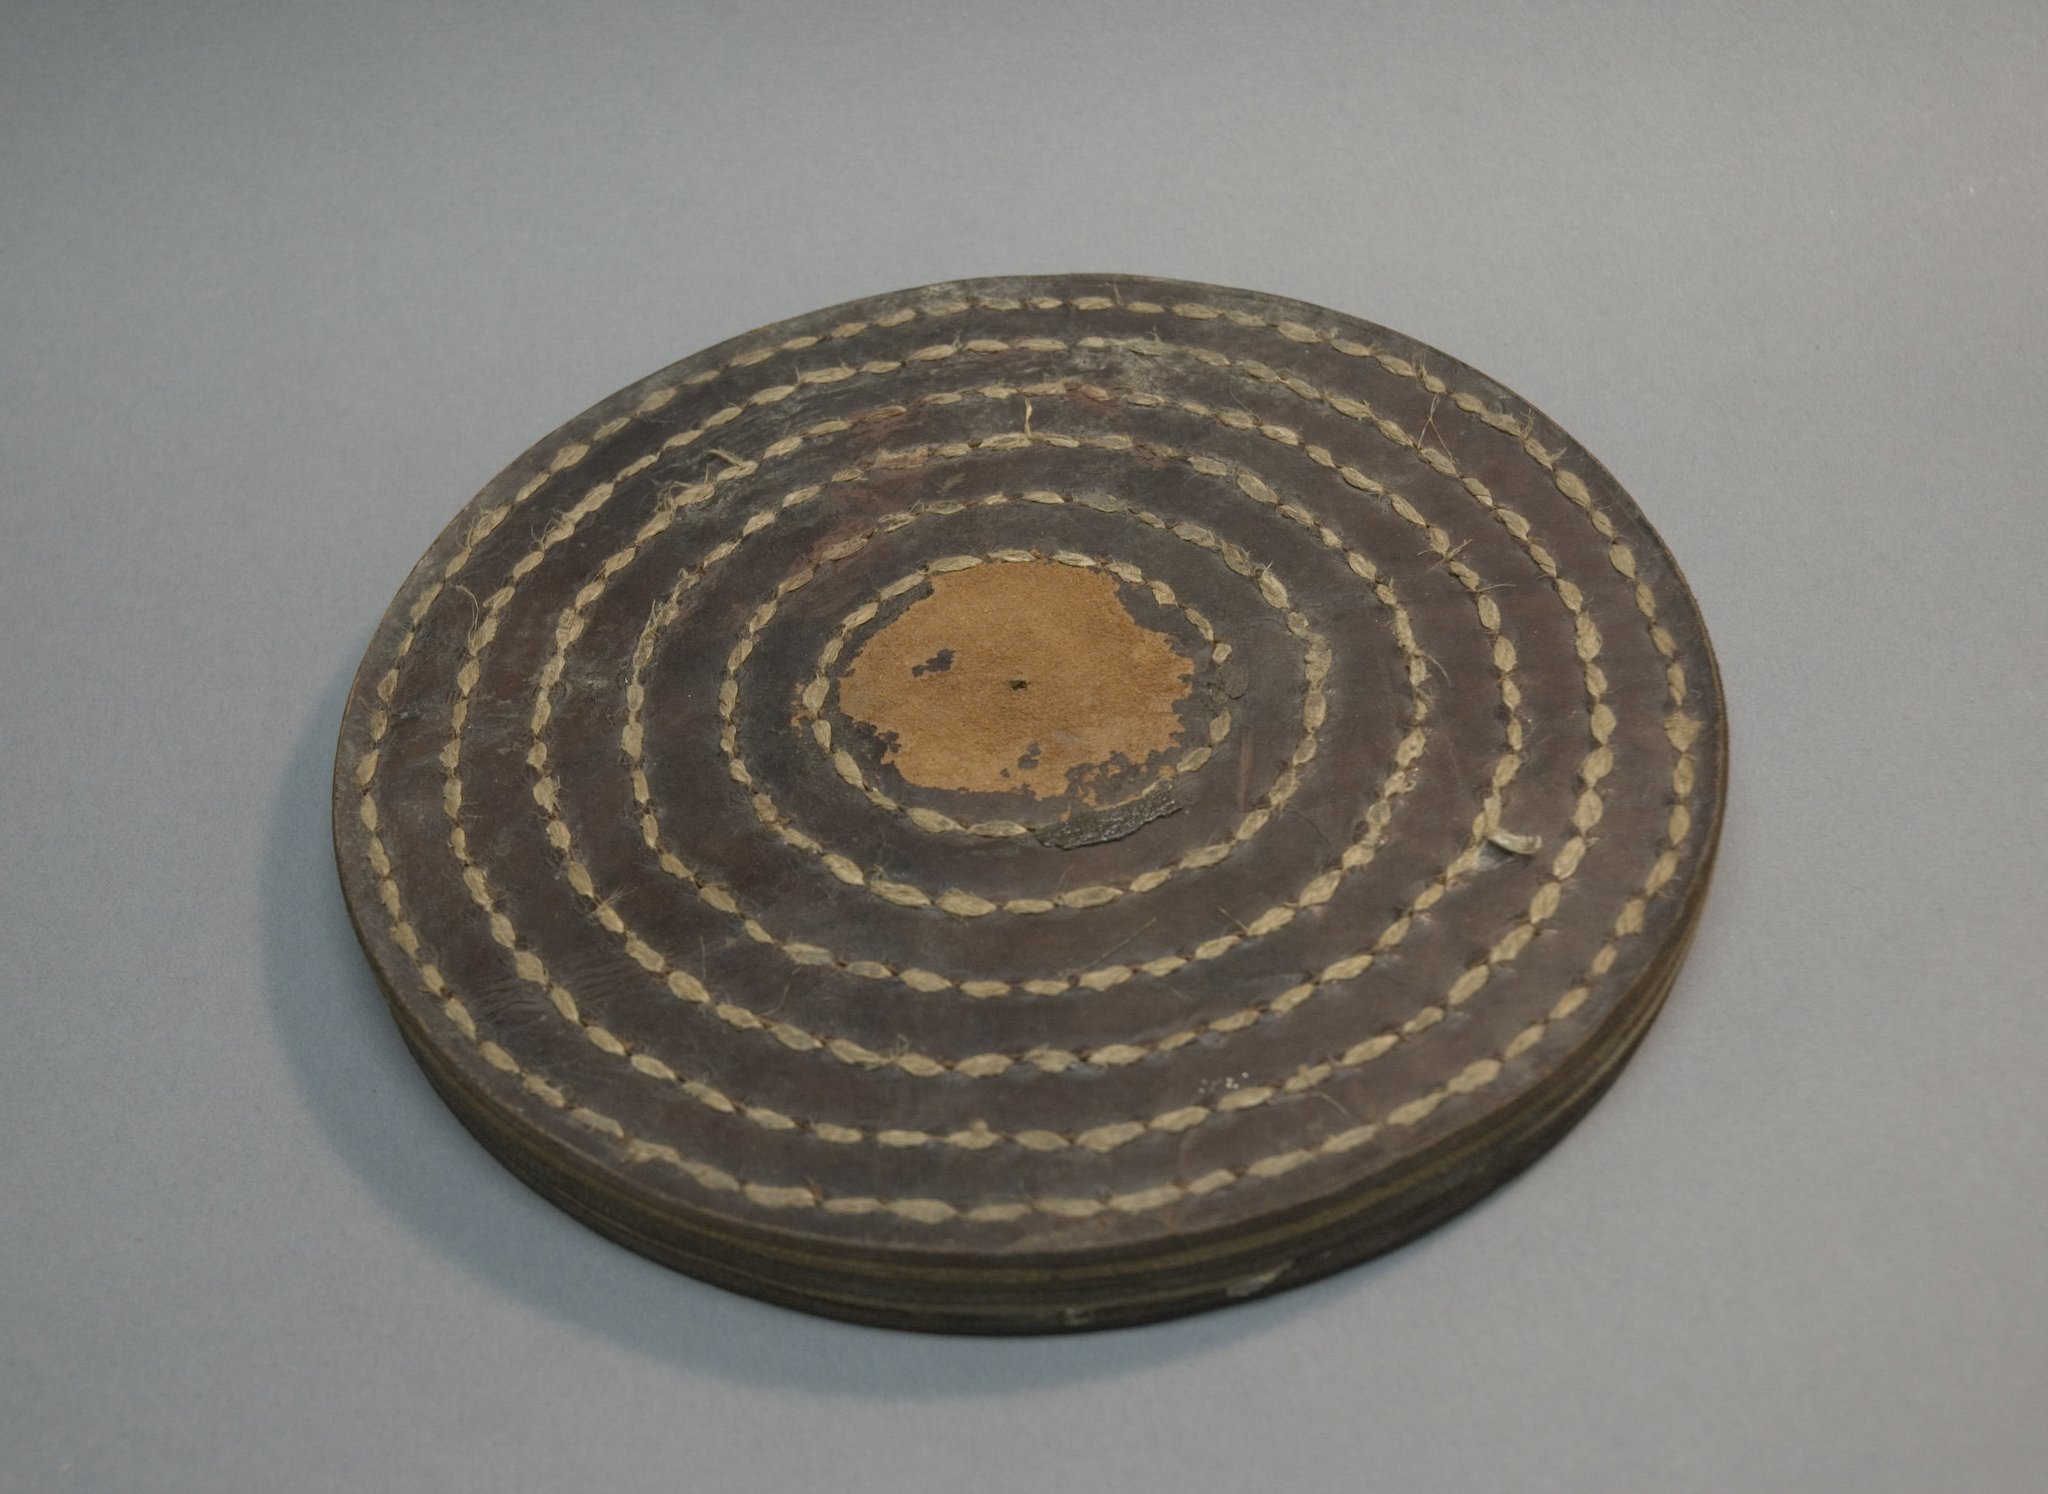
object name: jade carving tool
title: Polishing wheel for carving jade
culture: chinese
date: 1901-2000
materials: leather